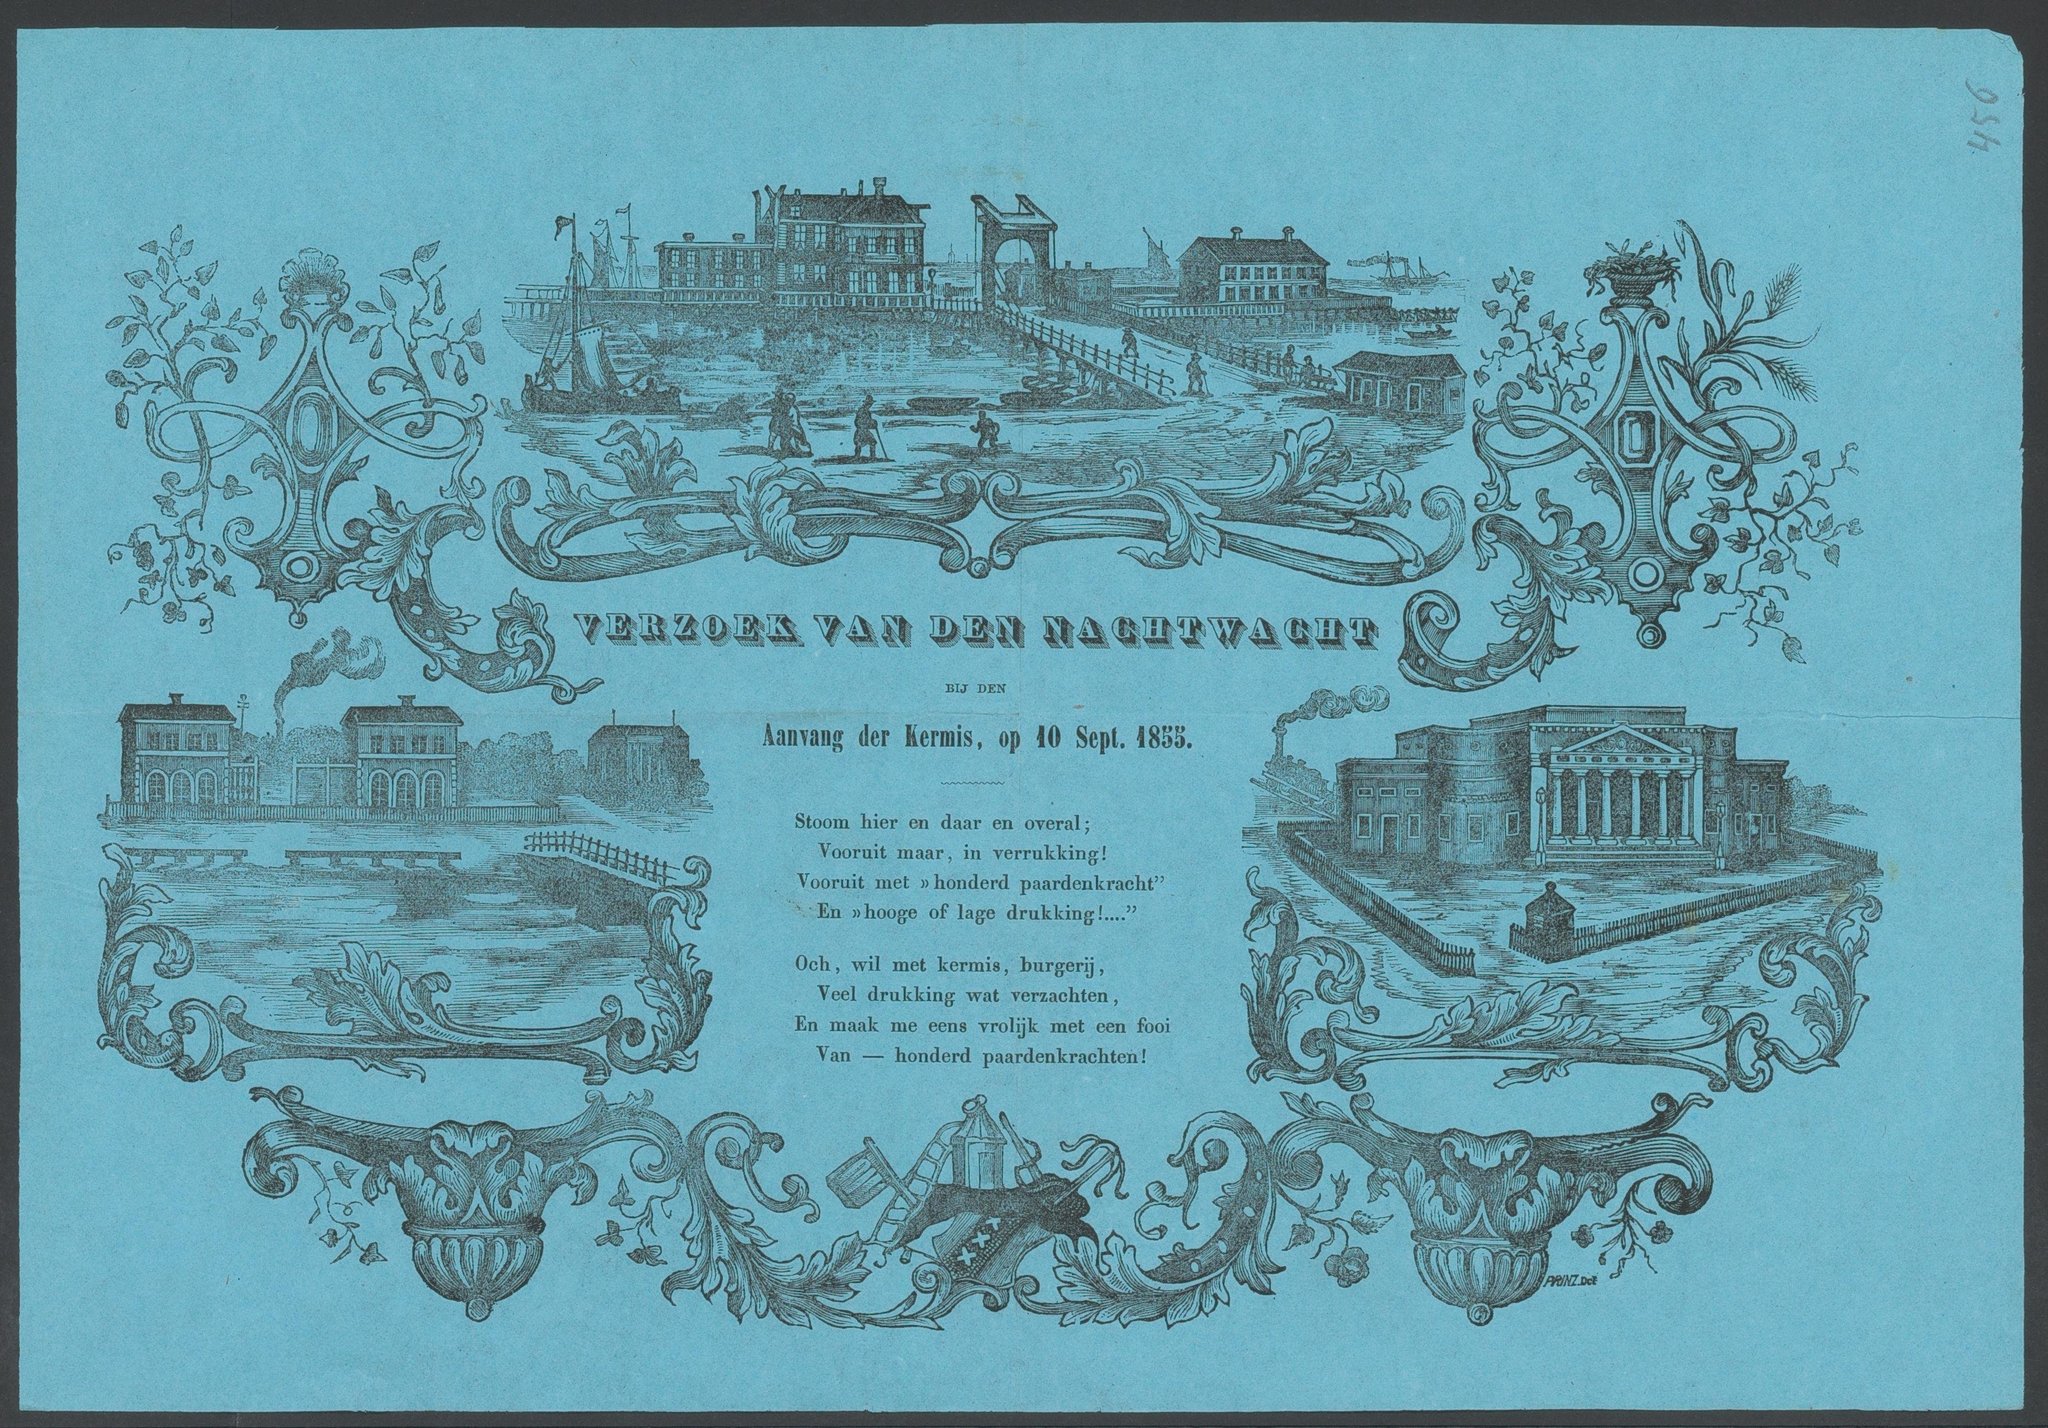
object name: print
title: Verzoek van den Nachtwacht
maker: friedrich robert prinz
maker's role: print maker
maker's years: 1820-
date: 1855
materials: paper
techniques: letterpress printing, engraving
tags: night patrol, amsterdam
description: Kermisprent van de Amsterdamse nachtwacht, 10 september 1855. Centraal een gedicht met daar omheen de Nieuwe stadsherberg, station Rhijnspoor en station Willemspoort. Onderwerpsrubrieken binnen de Atlas Zeden en Gewoonten: Zeden en gewoonten in engeren zin, Volksleven, Volksbladen, Nieuwjaars- en Kerstwenschen, Amsterdam.